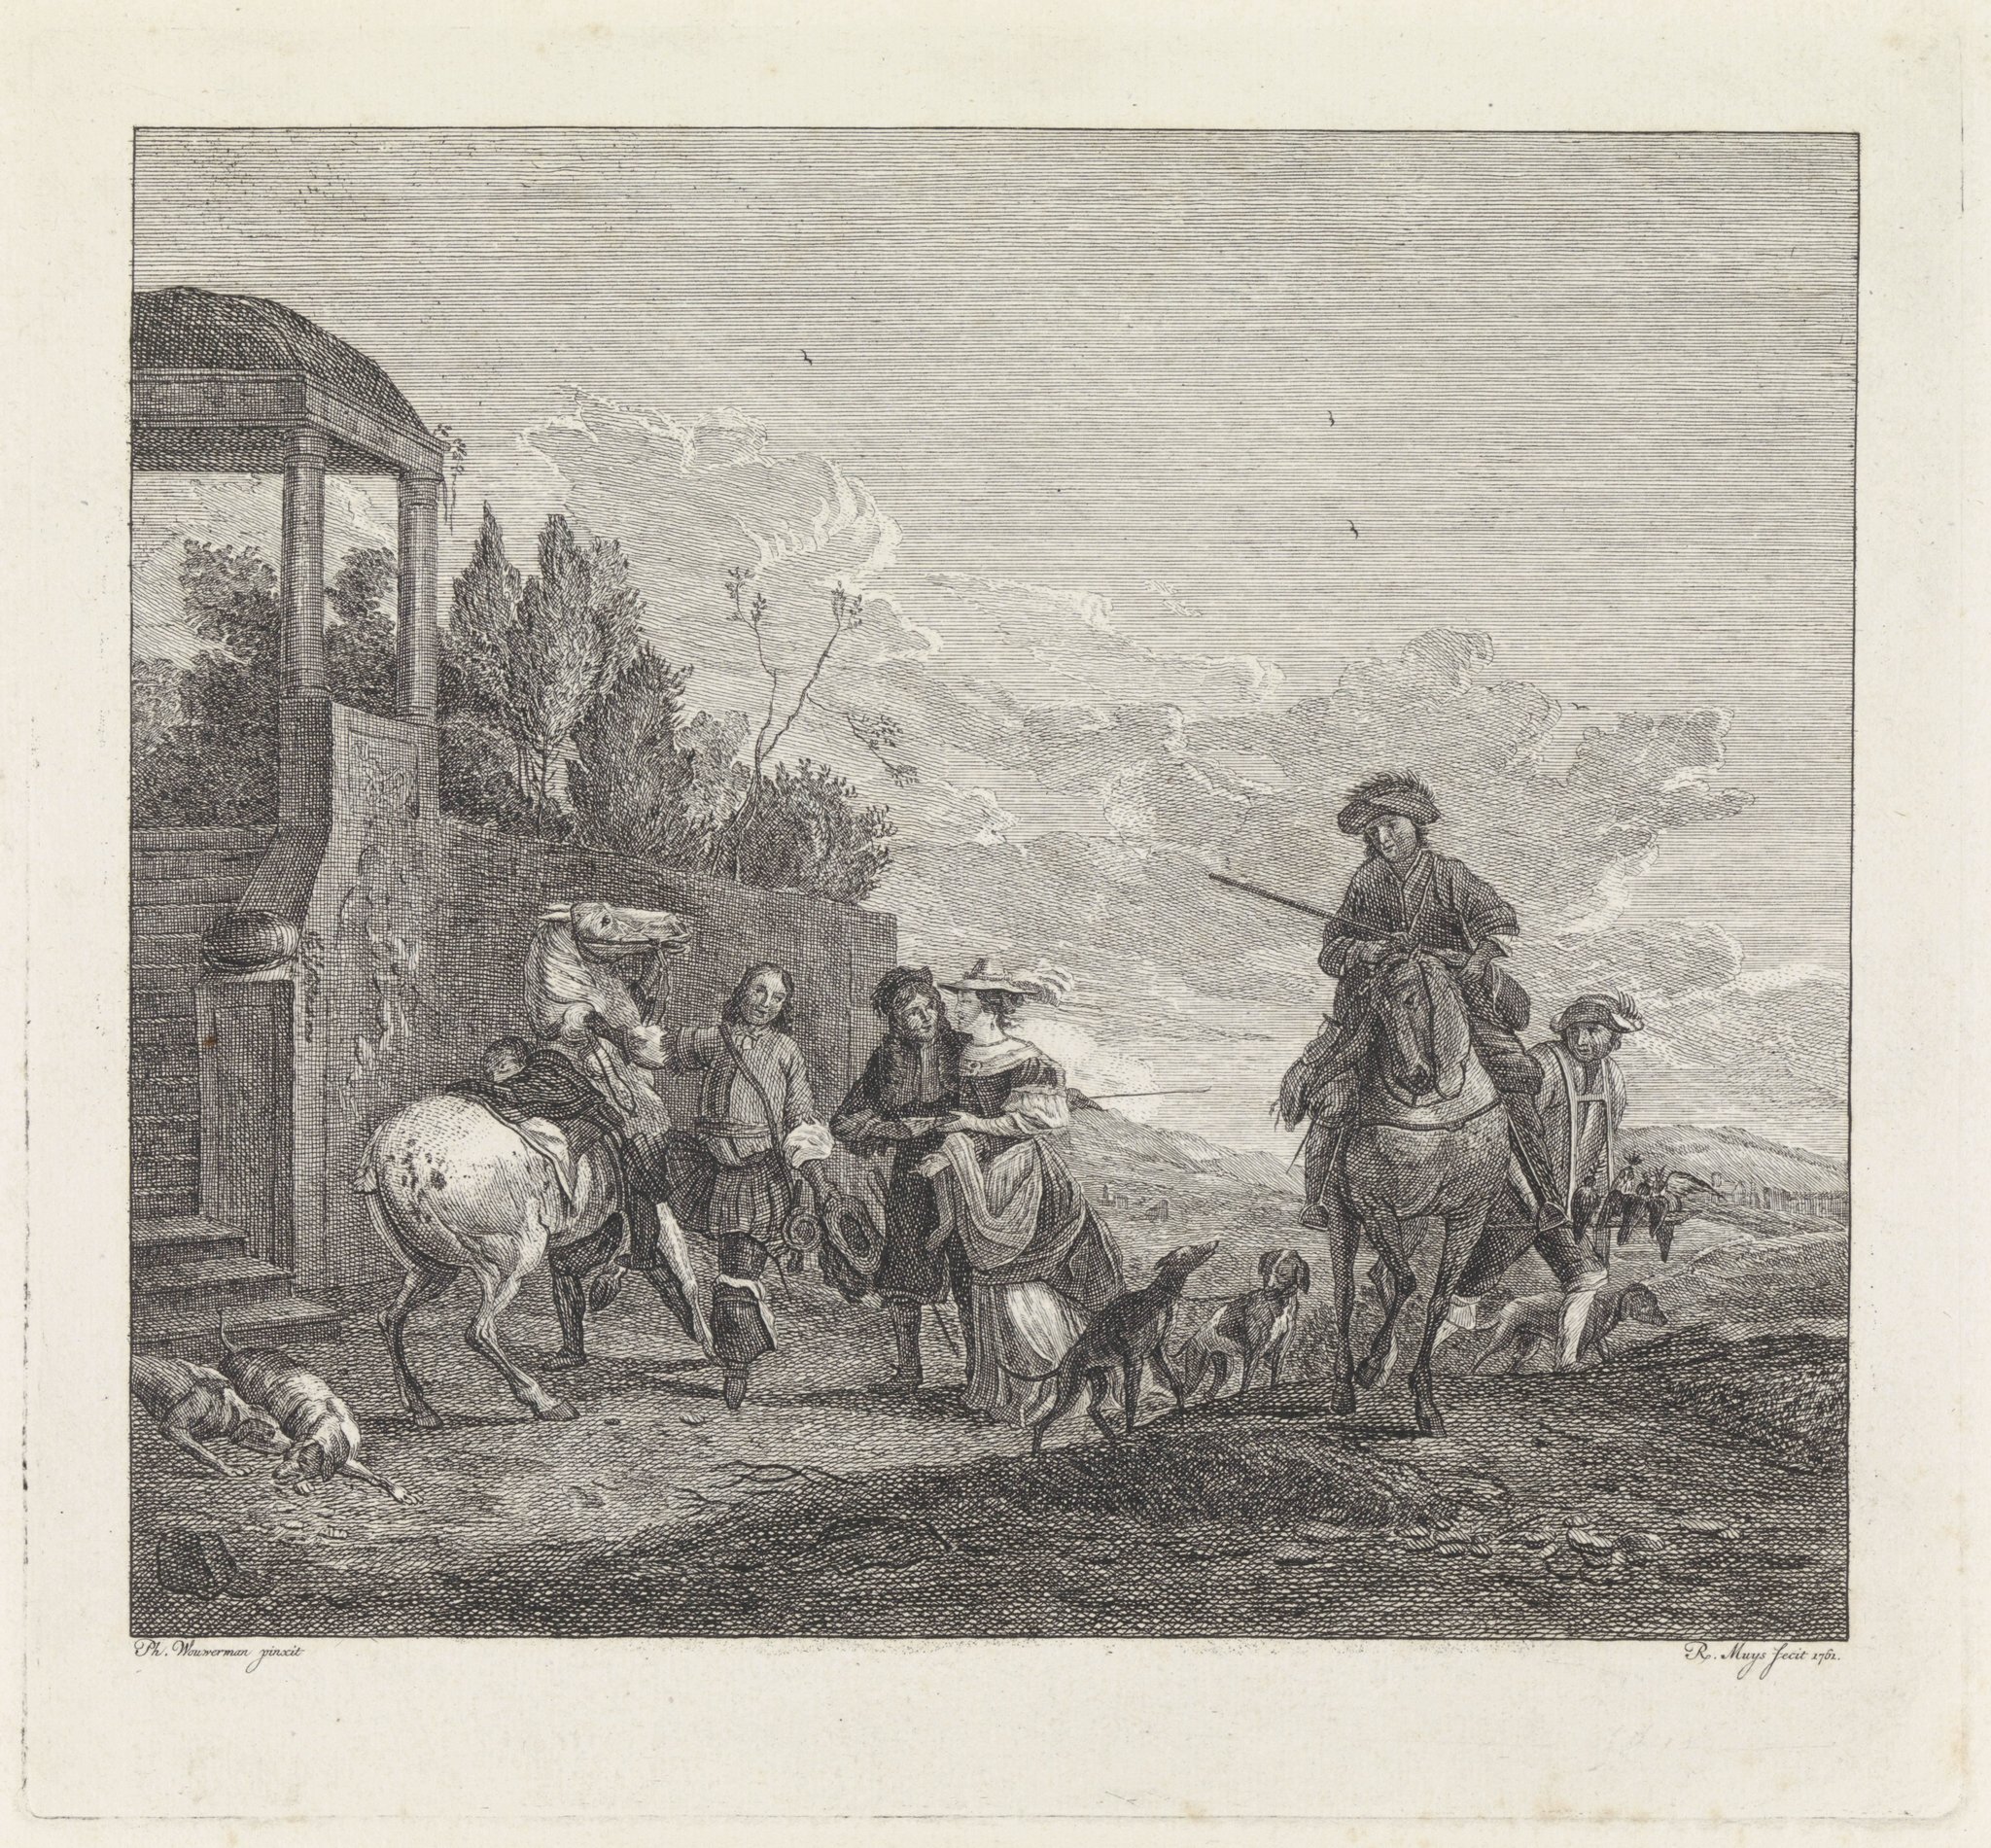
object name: print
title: Begin van de jacht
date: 1761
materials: paper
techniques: etching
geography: rotterdam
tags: hunting dogs, assembling, 'départ pour la chasse', fowling, fowler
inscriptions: collector's mark: Lugt 2228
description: Bij een schimmel staat een ruiter met één voet in de stijgbeugel. Naast hem staan een man en een vrouw. Rechts een man te paard en een valkenier. Tussen de figuren verschillende jachthonden, rechts een muur, een overkapping en een trap.